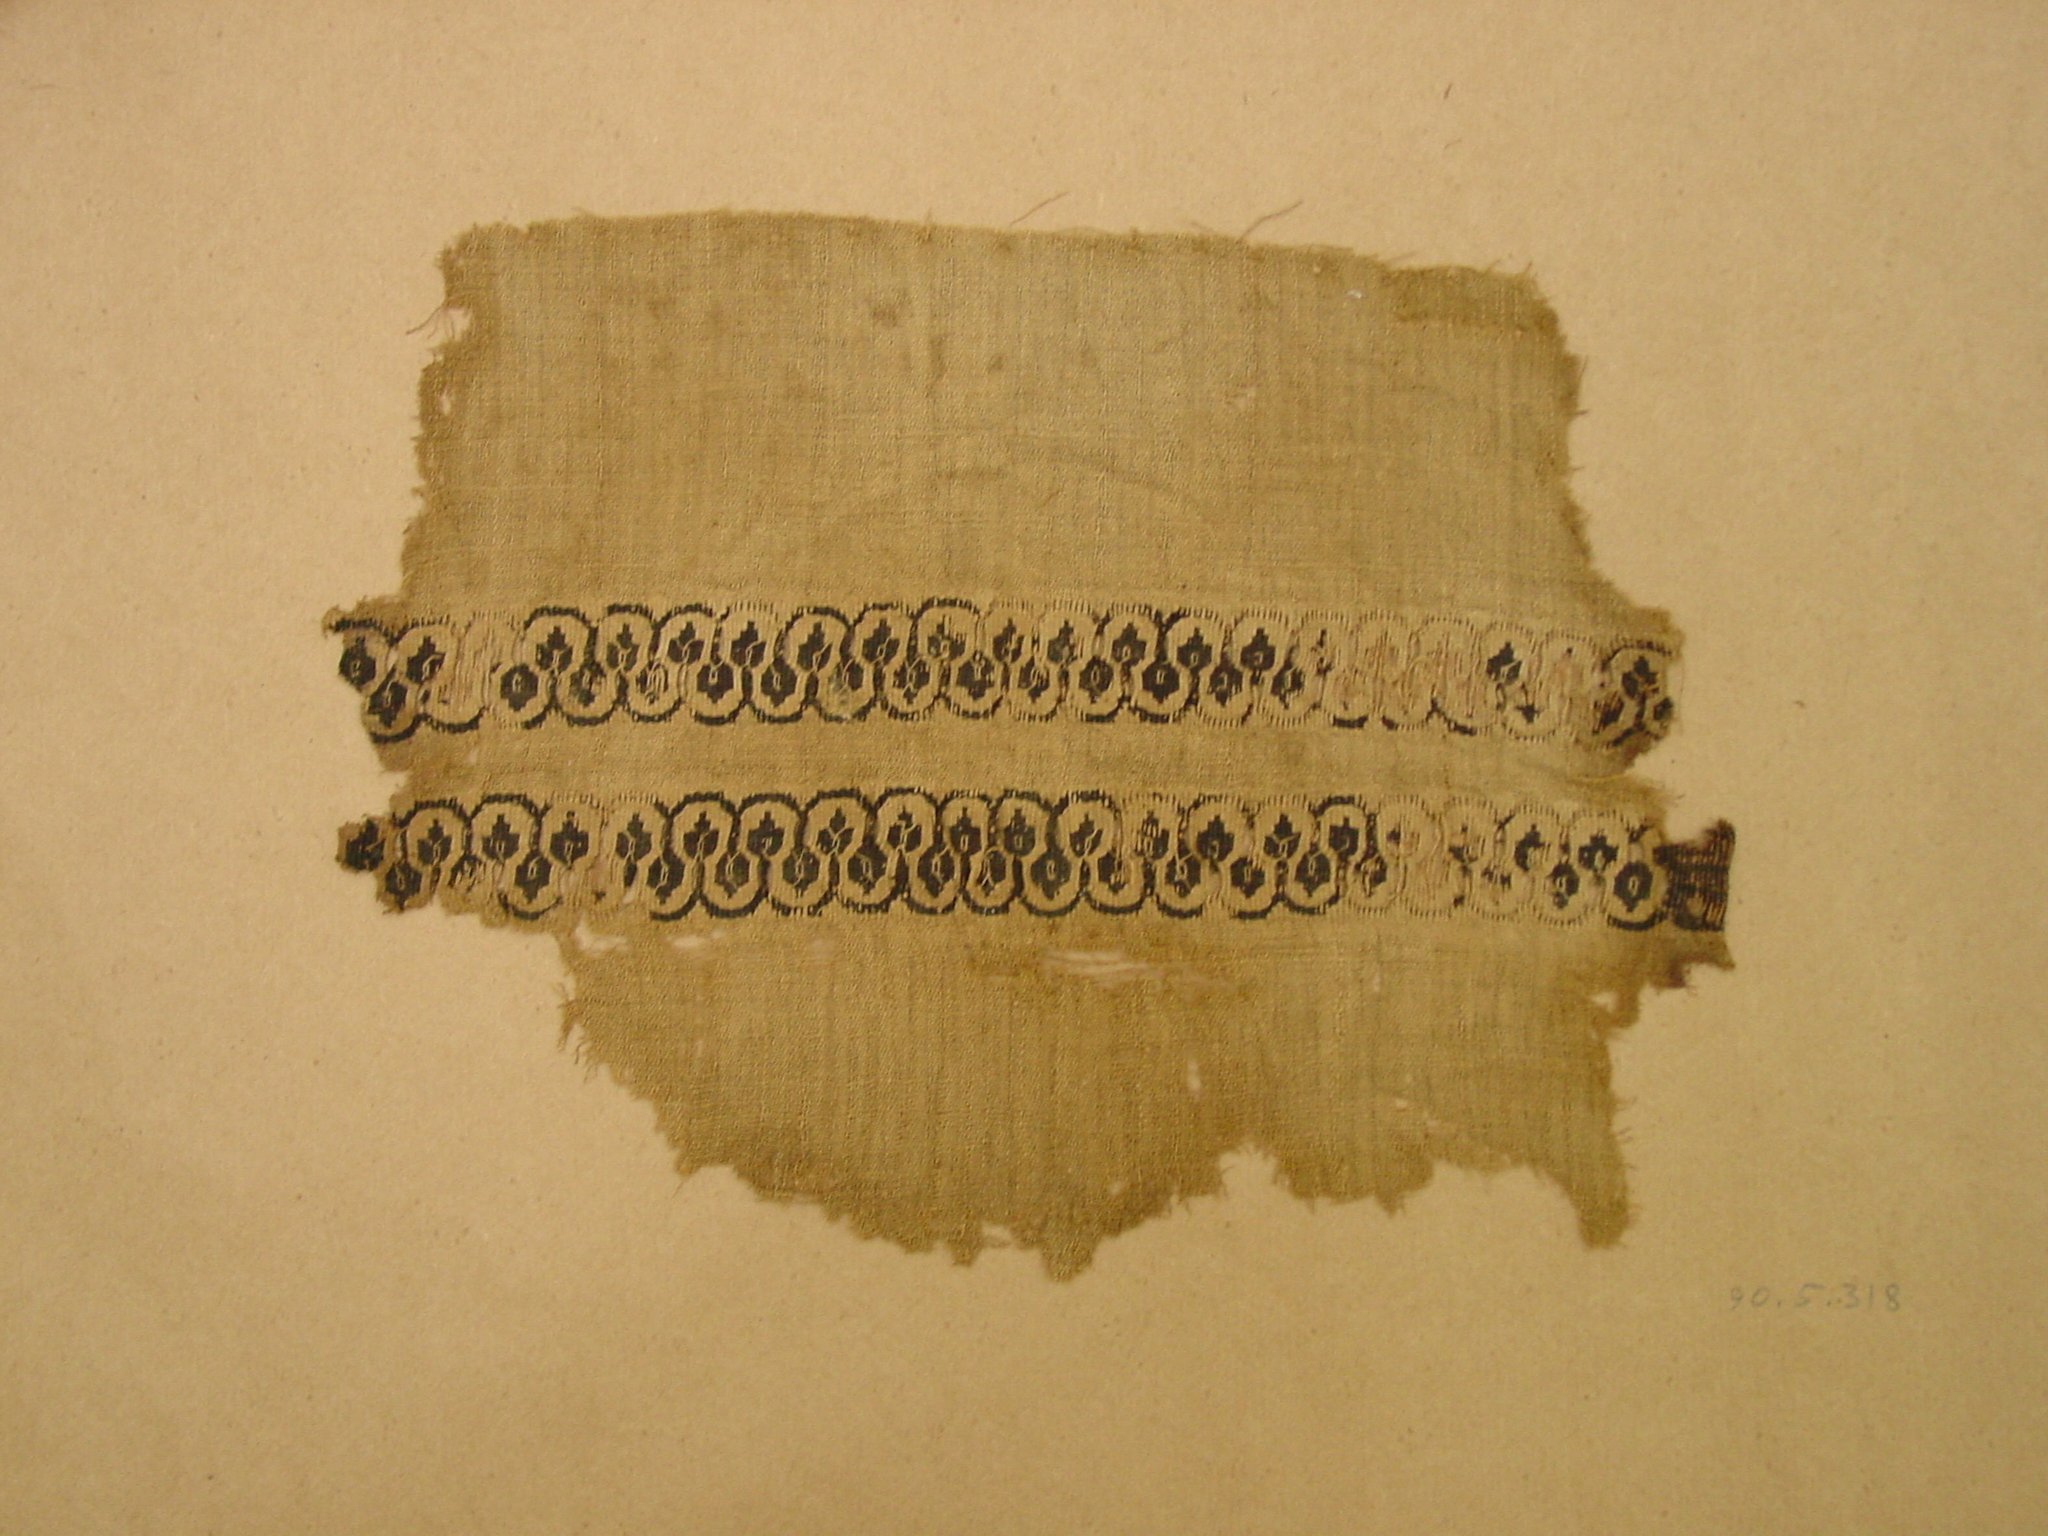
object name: textile fragment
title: Fragment of a Sleeve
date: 201-400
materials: linen, wool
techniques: weave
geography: egypt